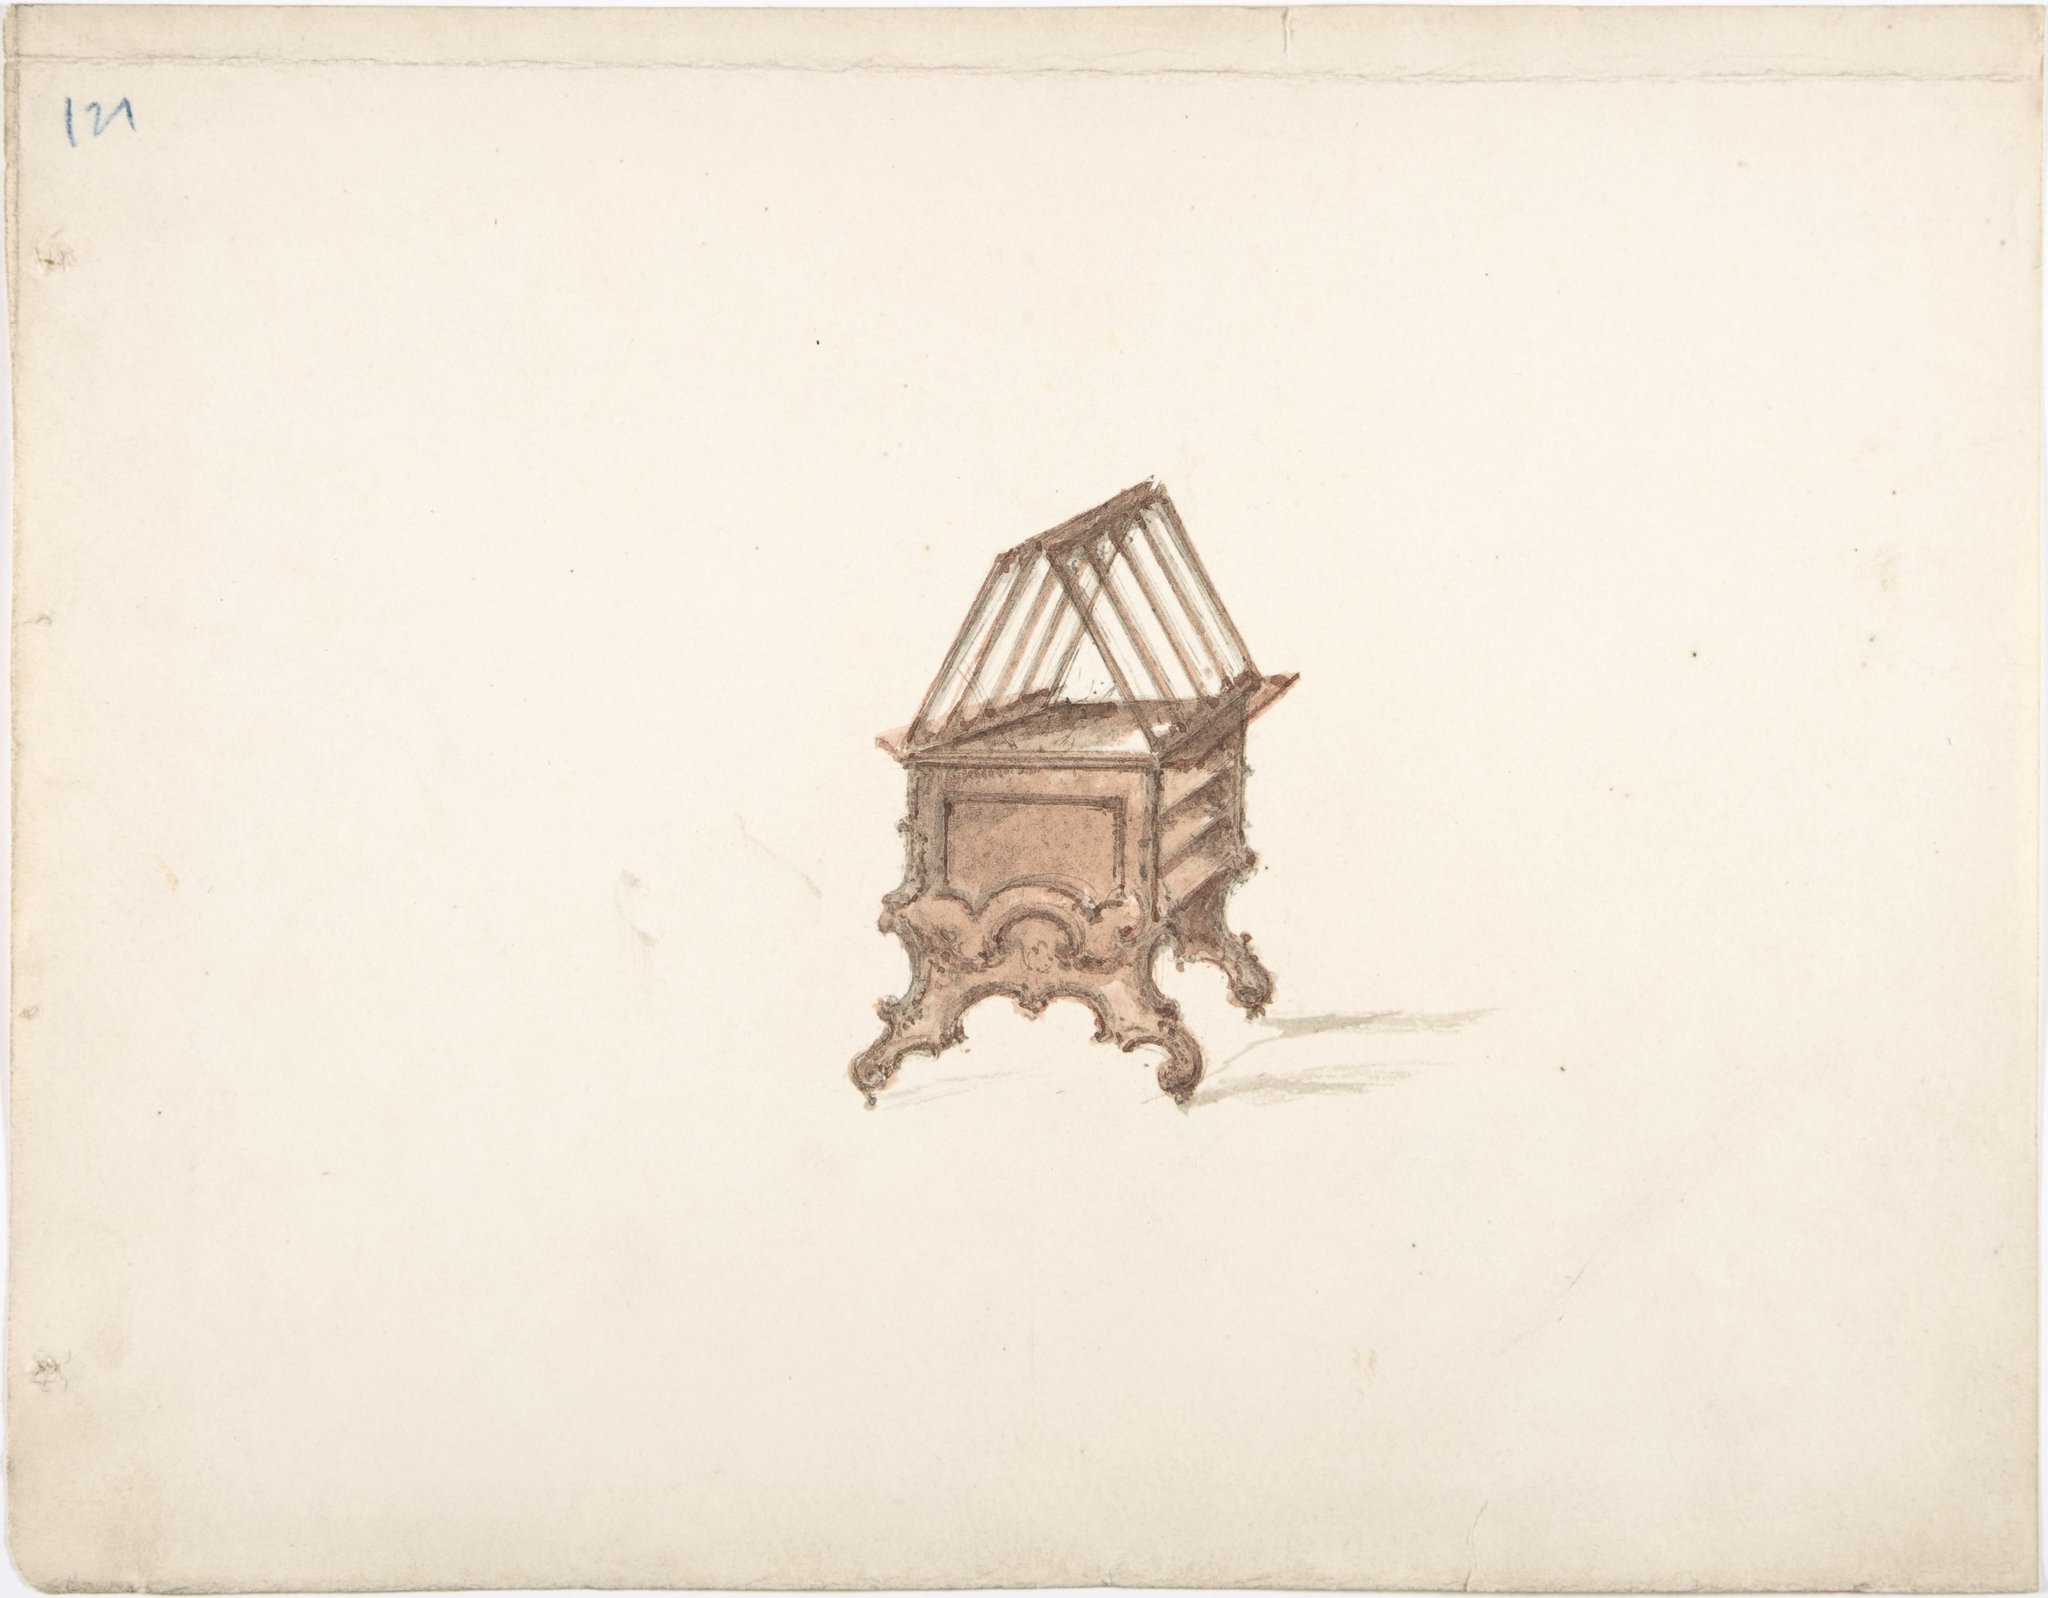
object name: drawing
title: Design for a Two-sided Bookstand with Shelves (Verso: sketch)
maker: anonymous, british, 19th century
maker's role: artist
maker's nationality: british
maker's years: 1800-1900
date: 1801-1833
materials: ink, watercolor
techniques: brush, pen, wash